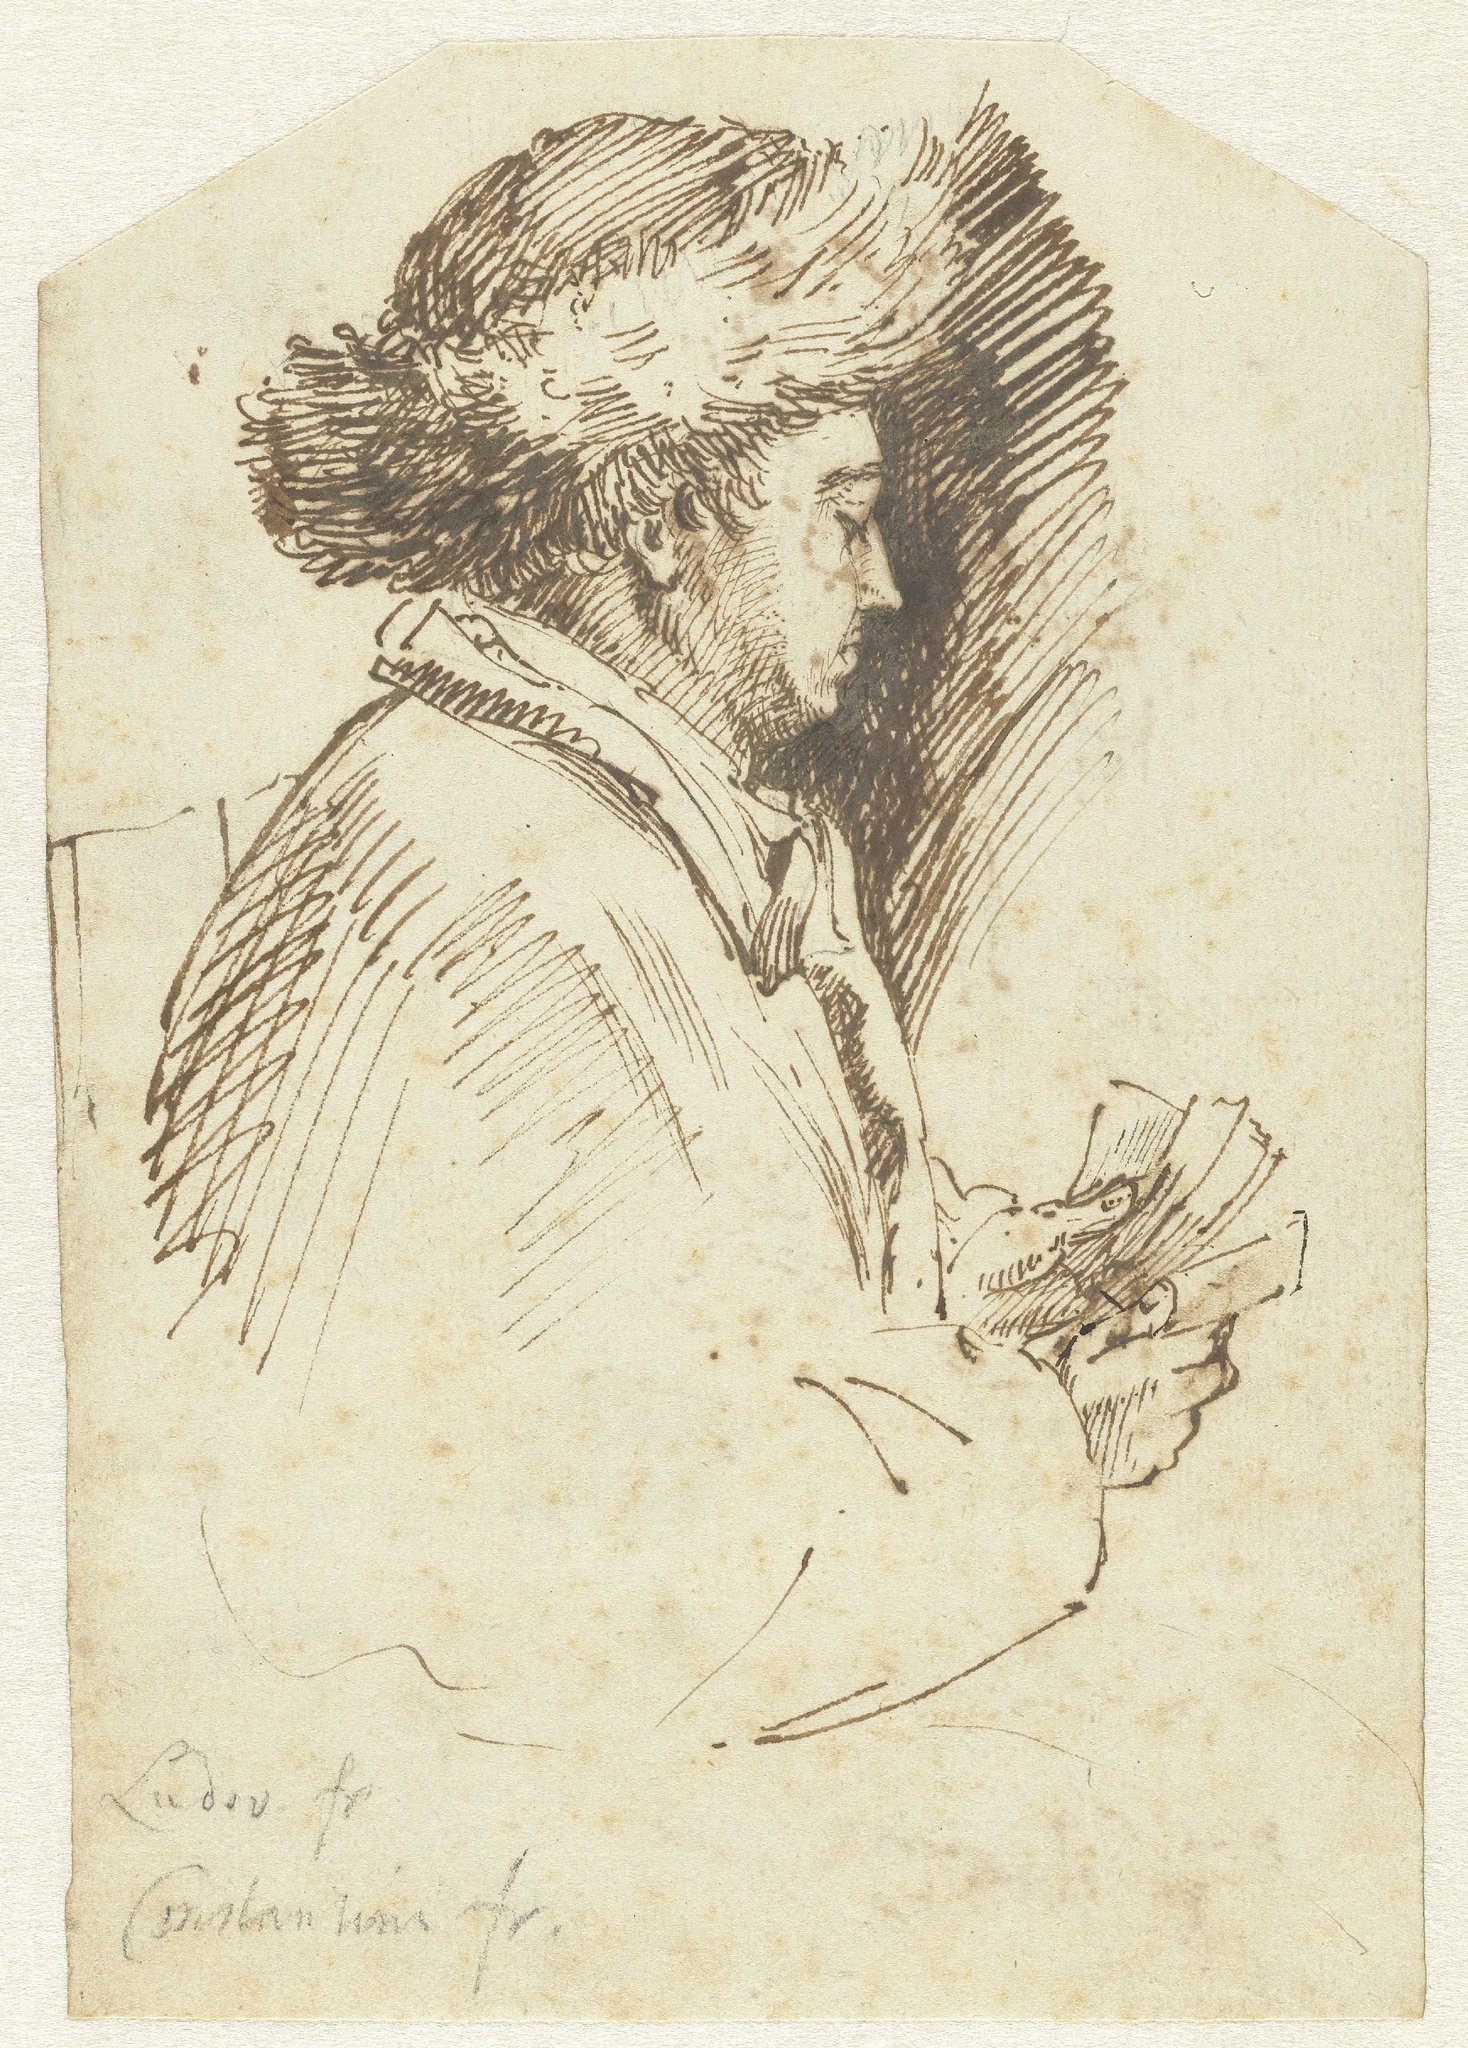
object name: drawing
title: Portret van Lodewijk Huygens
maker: constantijn huygens (ii)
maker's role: draughtsman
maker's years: 1628-1697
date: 1669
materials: graphite, ink, paper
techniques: pen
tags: historical persons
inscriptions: date: ‘6. nov. 1669.’